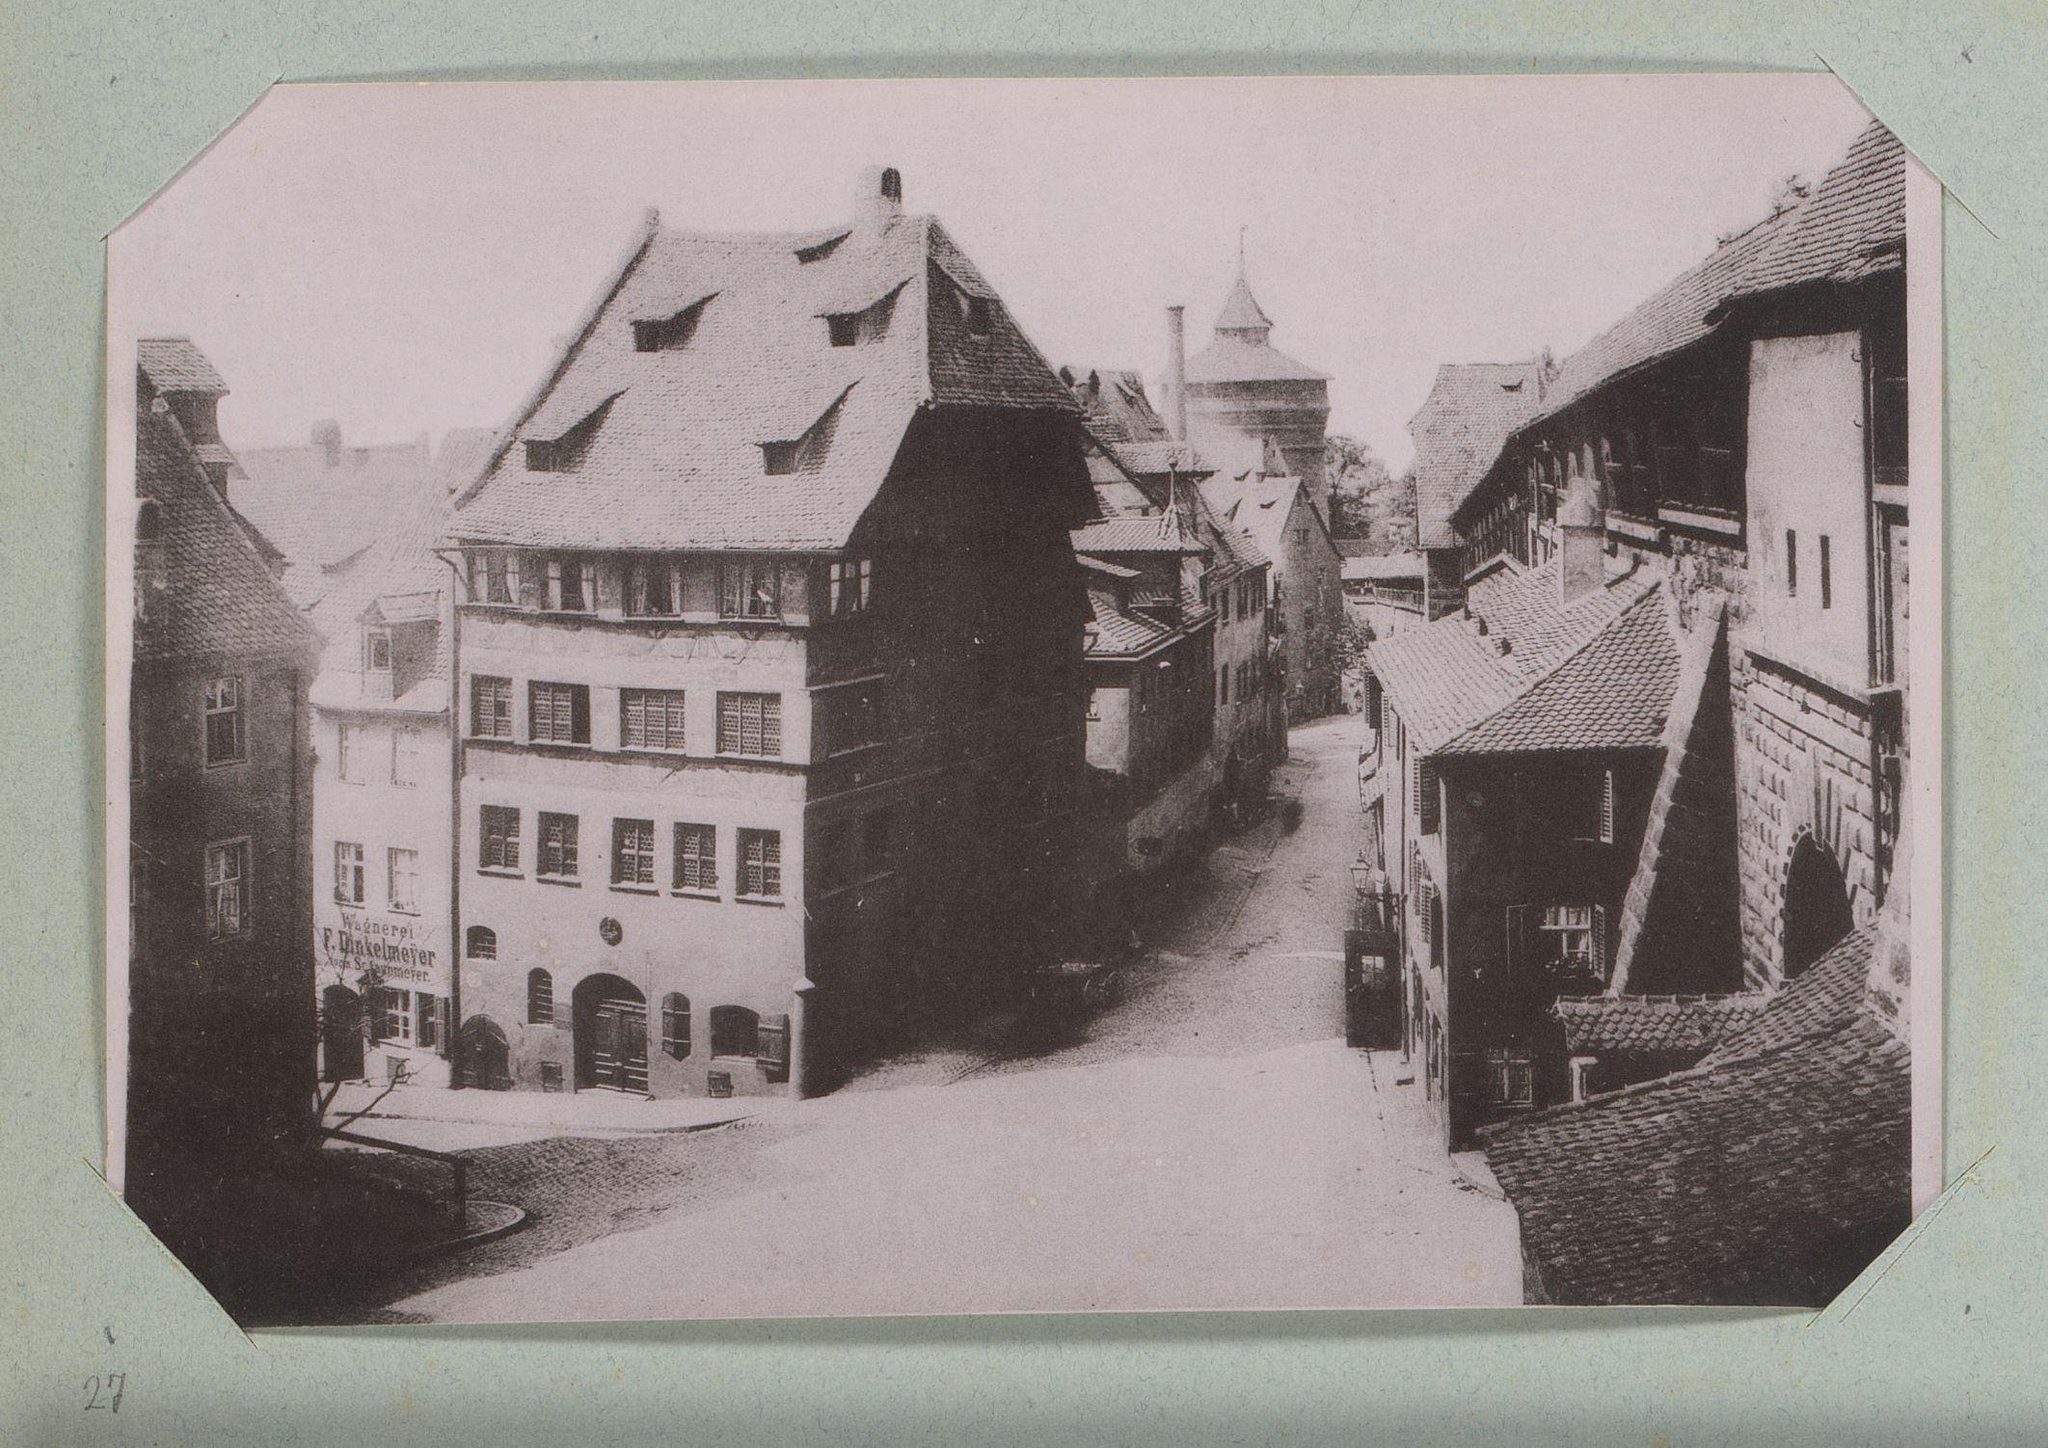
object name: photomechanical print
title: Albrecht-Dürer-Haus, Neurenberg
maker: Anonymous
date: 1890-1900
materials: paper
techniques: photograph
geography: nuremberg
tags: urban housing, street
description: Deze prent maakt deel uit van een album.